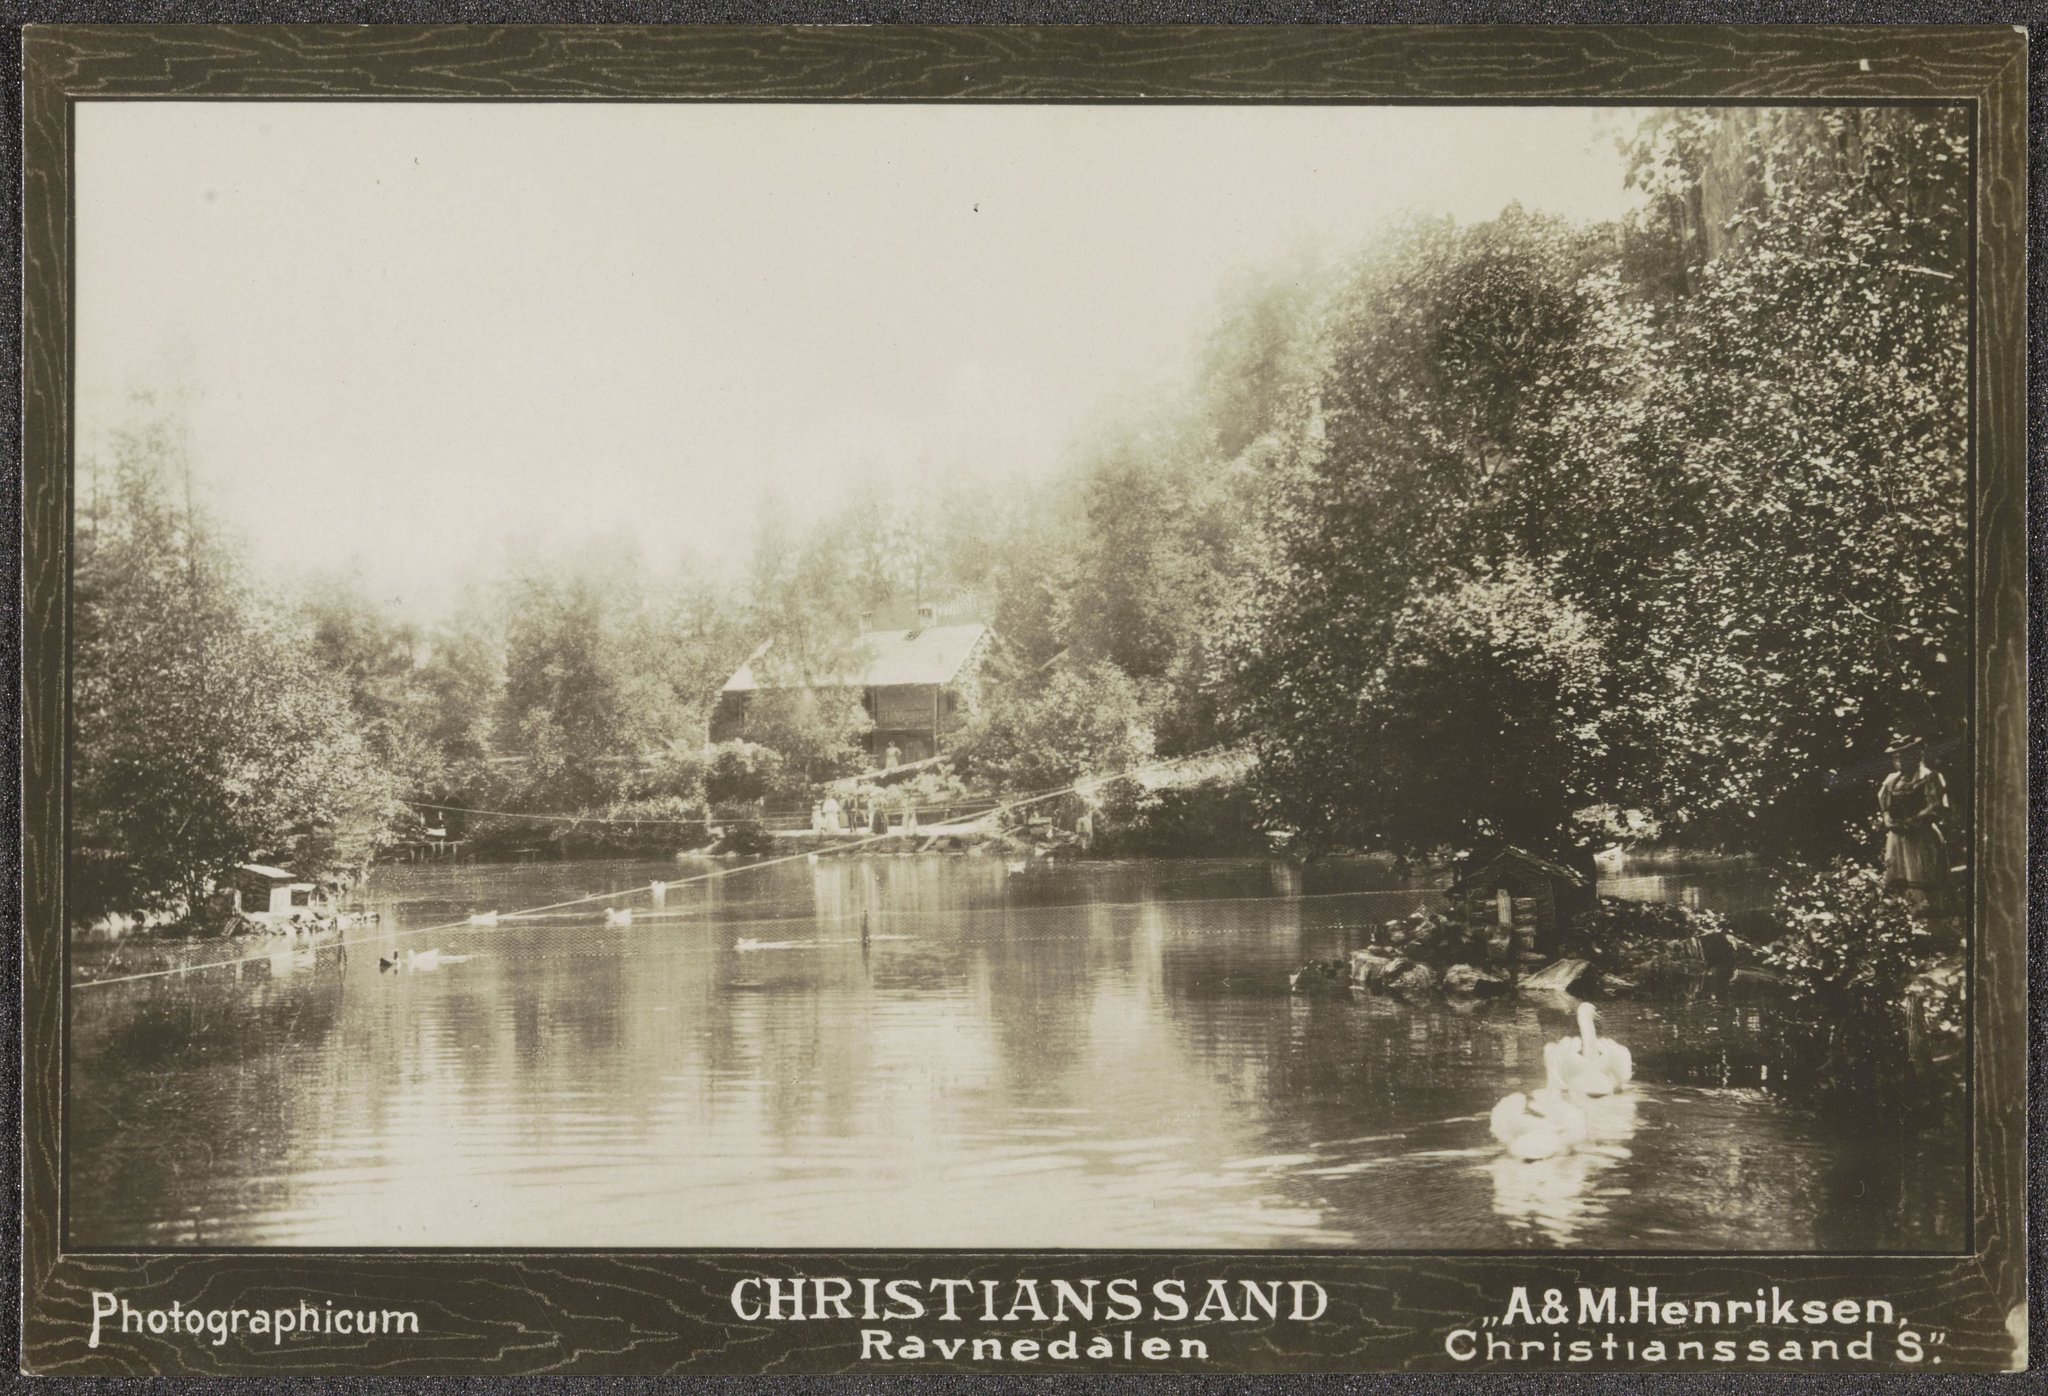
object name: ansichtkaart, prentbriefkaart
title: Christianssand Ravnedalen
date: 1870-1898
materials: photographic support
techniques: gelatin silver print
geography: kristiansand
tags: public gardens, park (+ city(-scape) with figures, staffage), travelling; tourism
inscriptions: inscription: ‘Christianssand S.’, inscription: ‘Photographicum’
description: Foto hoort bij een serie van 28 losse prentbriefkaarten van Engeland, Noorwegen, Italië, Duitsland en Tirol (foto's RP-F-F00945-1 t/m RP-F-F00945-28).